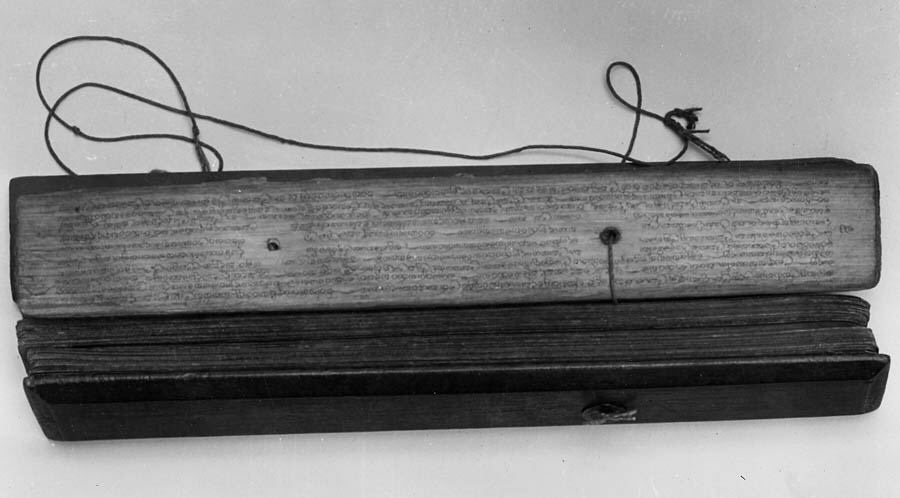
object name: manuscript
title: Pali Manuscript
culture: south indian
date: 1701-1800